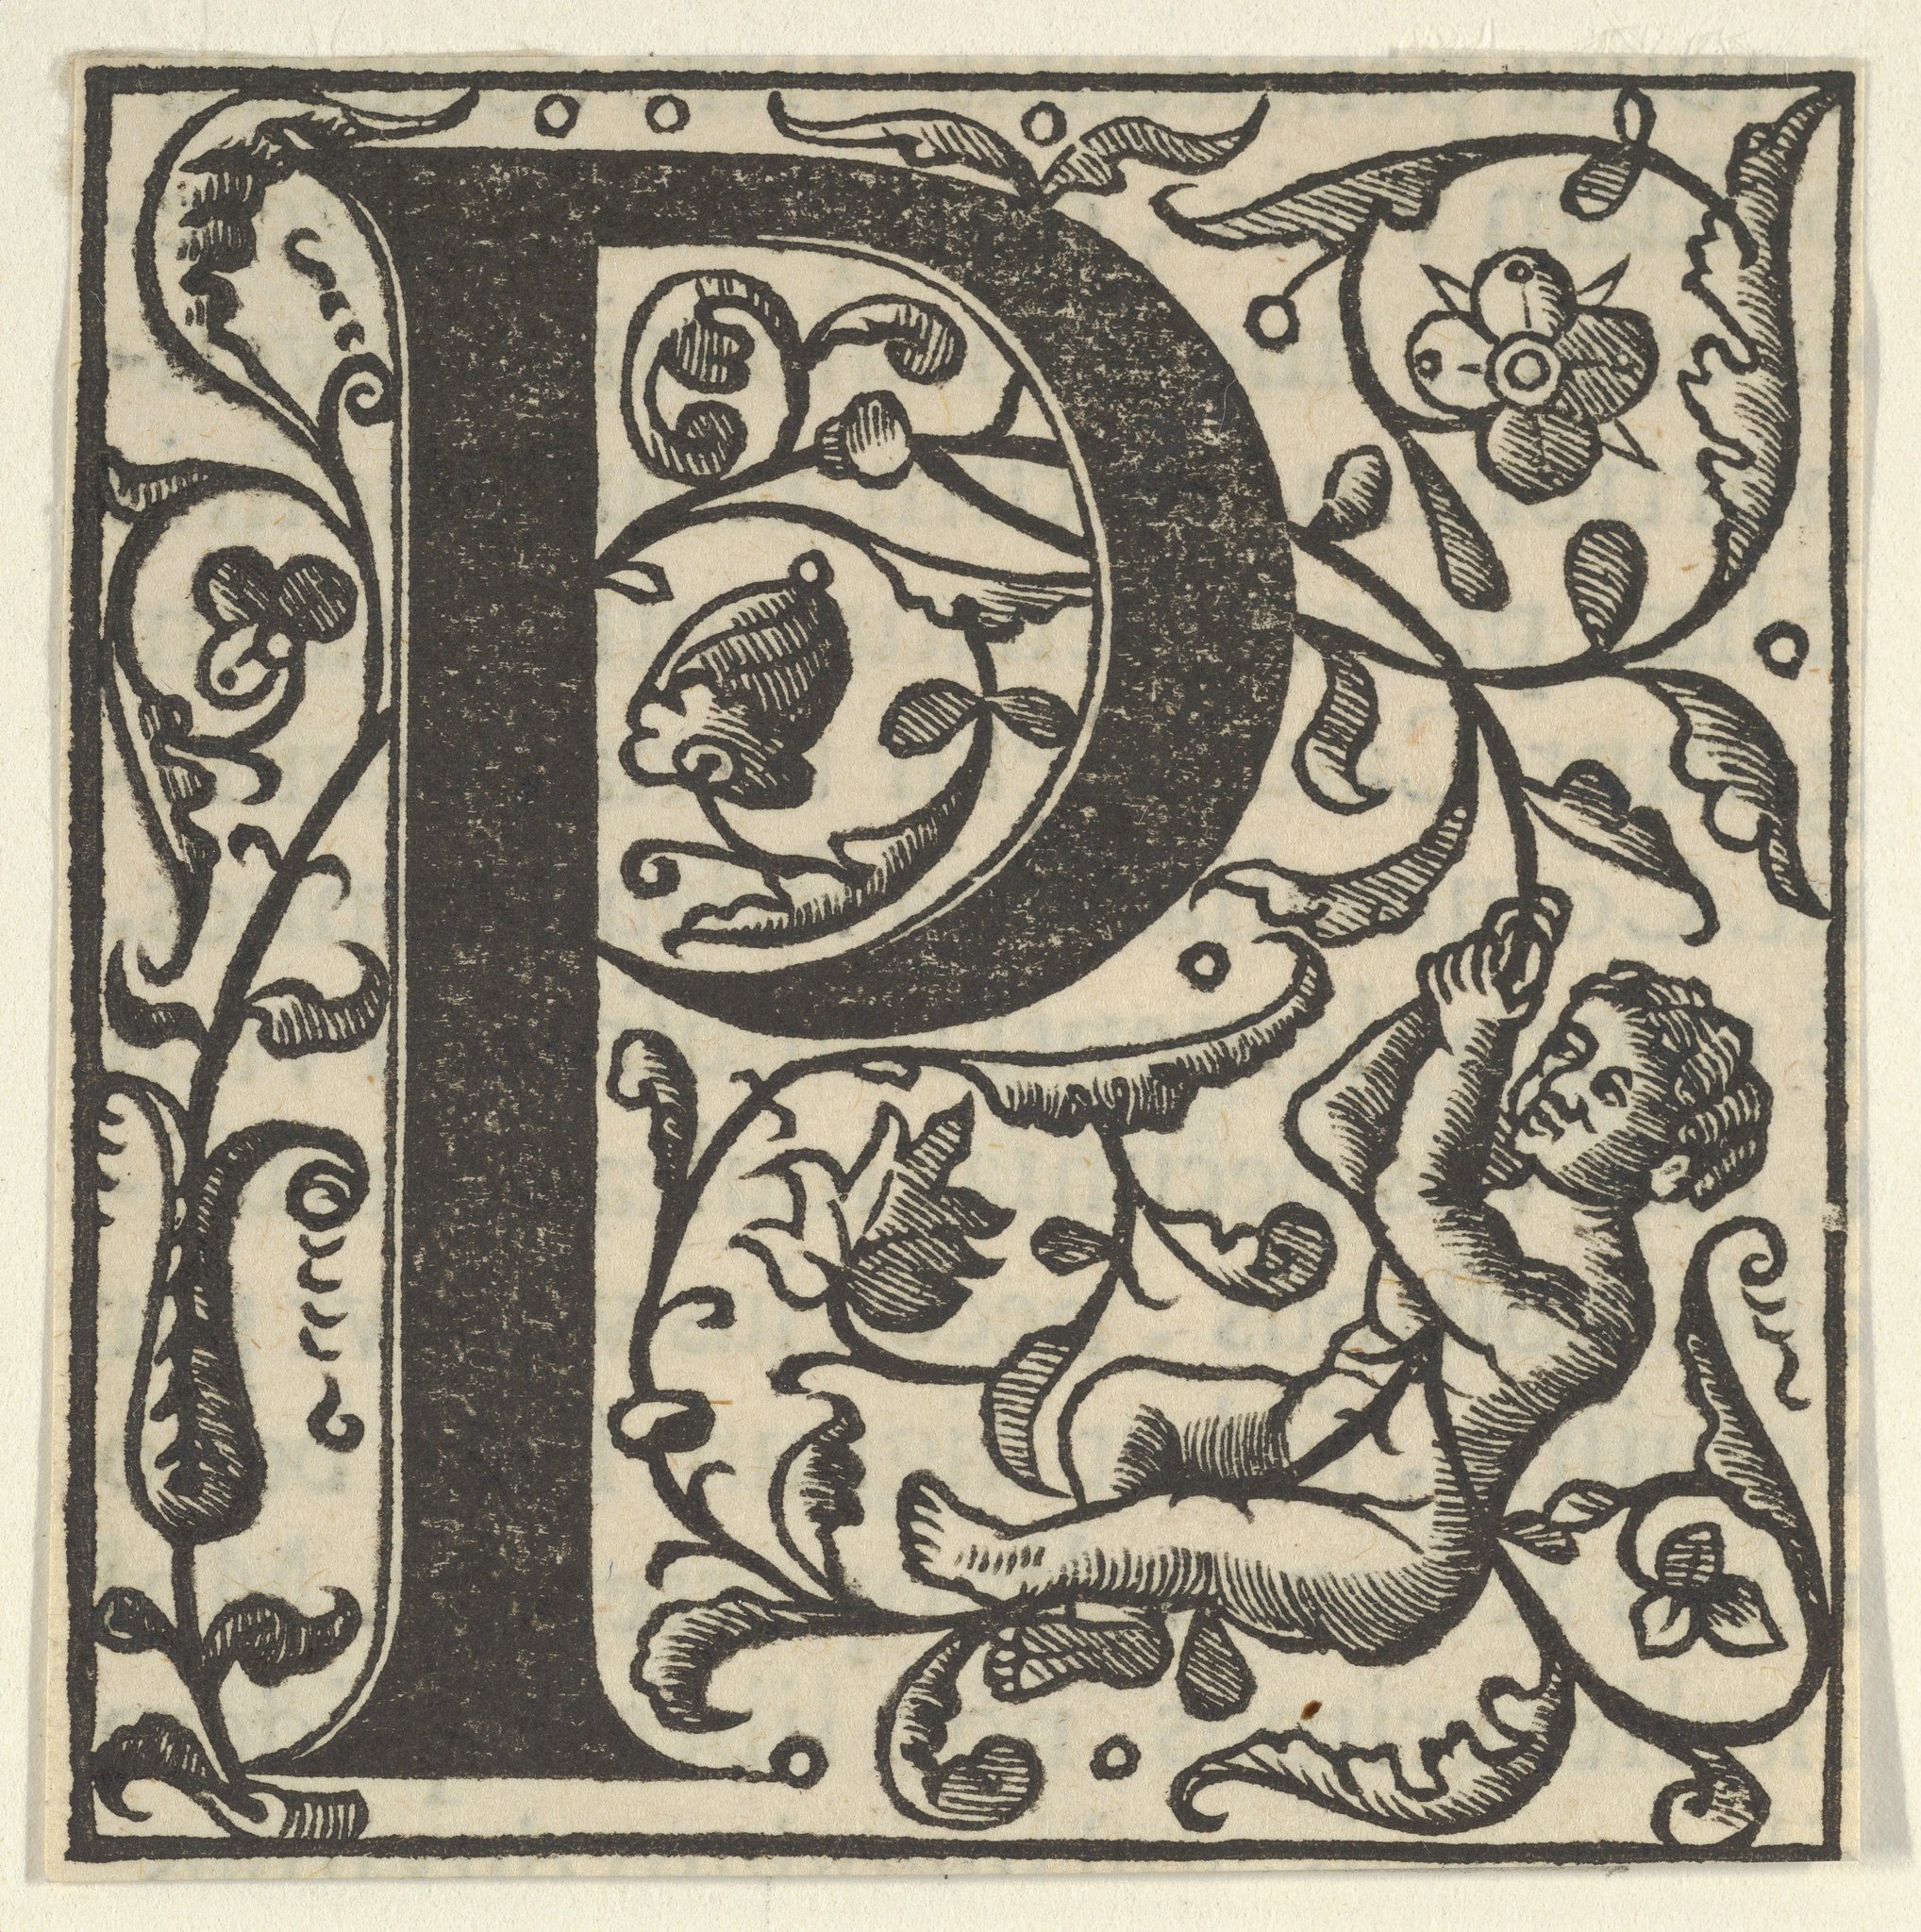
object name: print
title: Initial letter P with putto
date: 1534-1566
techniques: woodcut